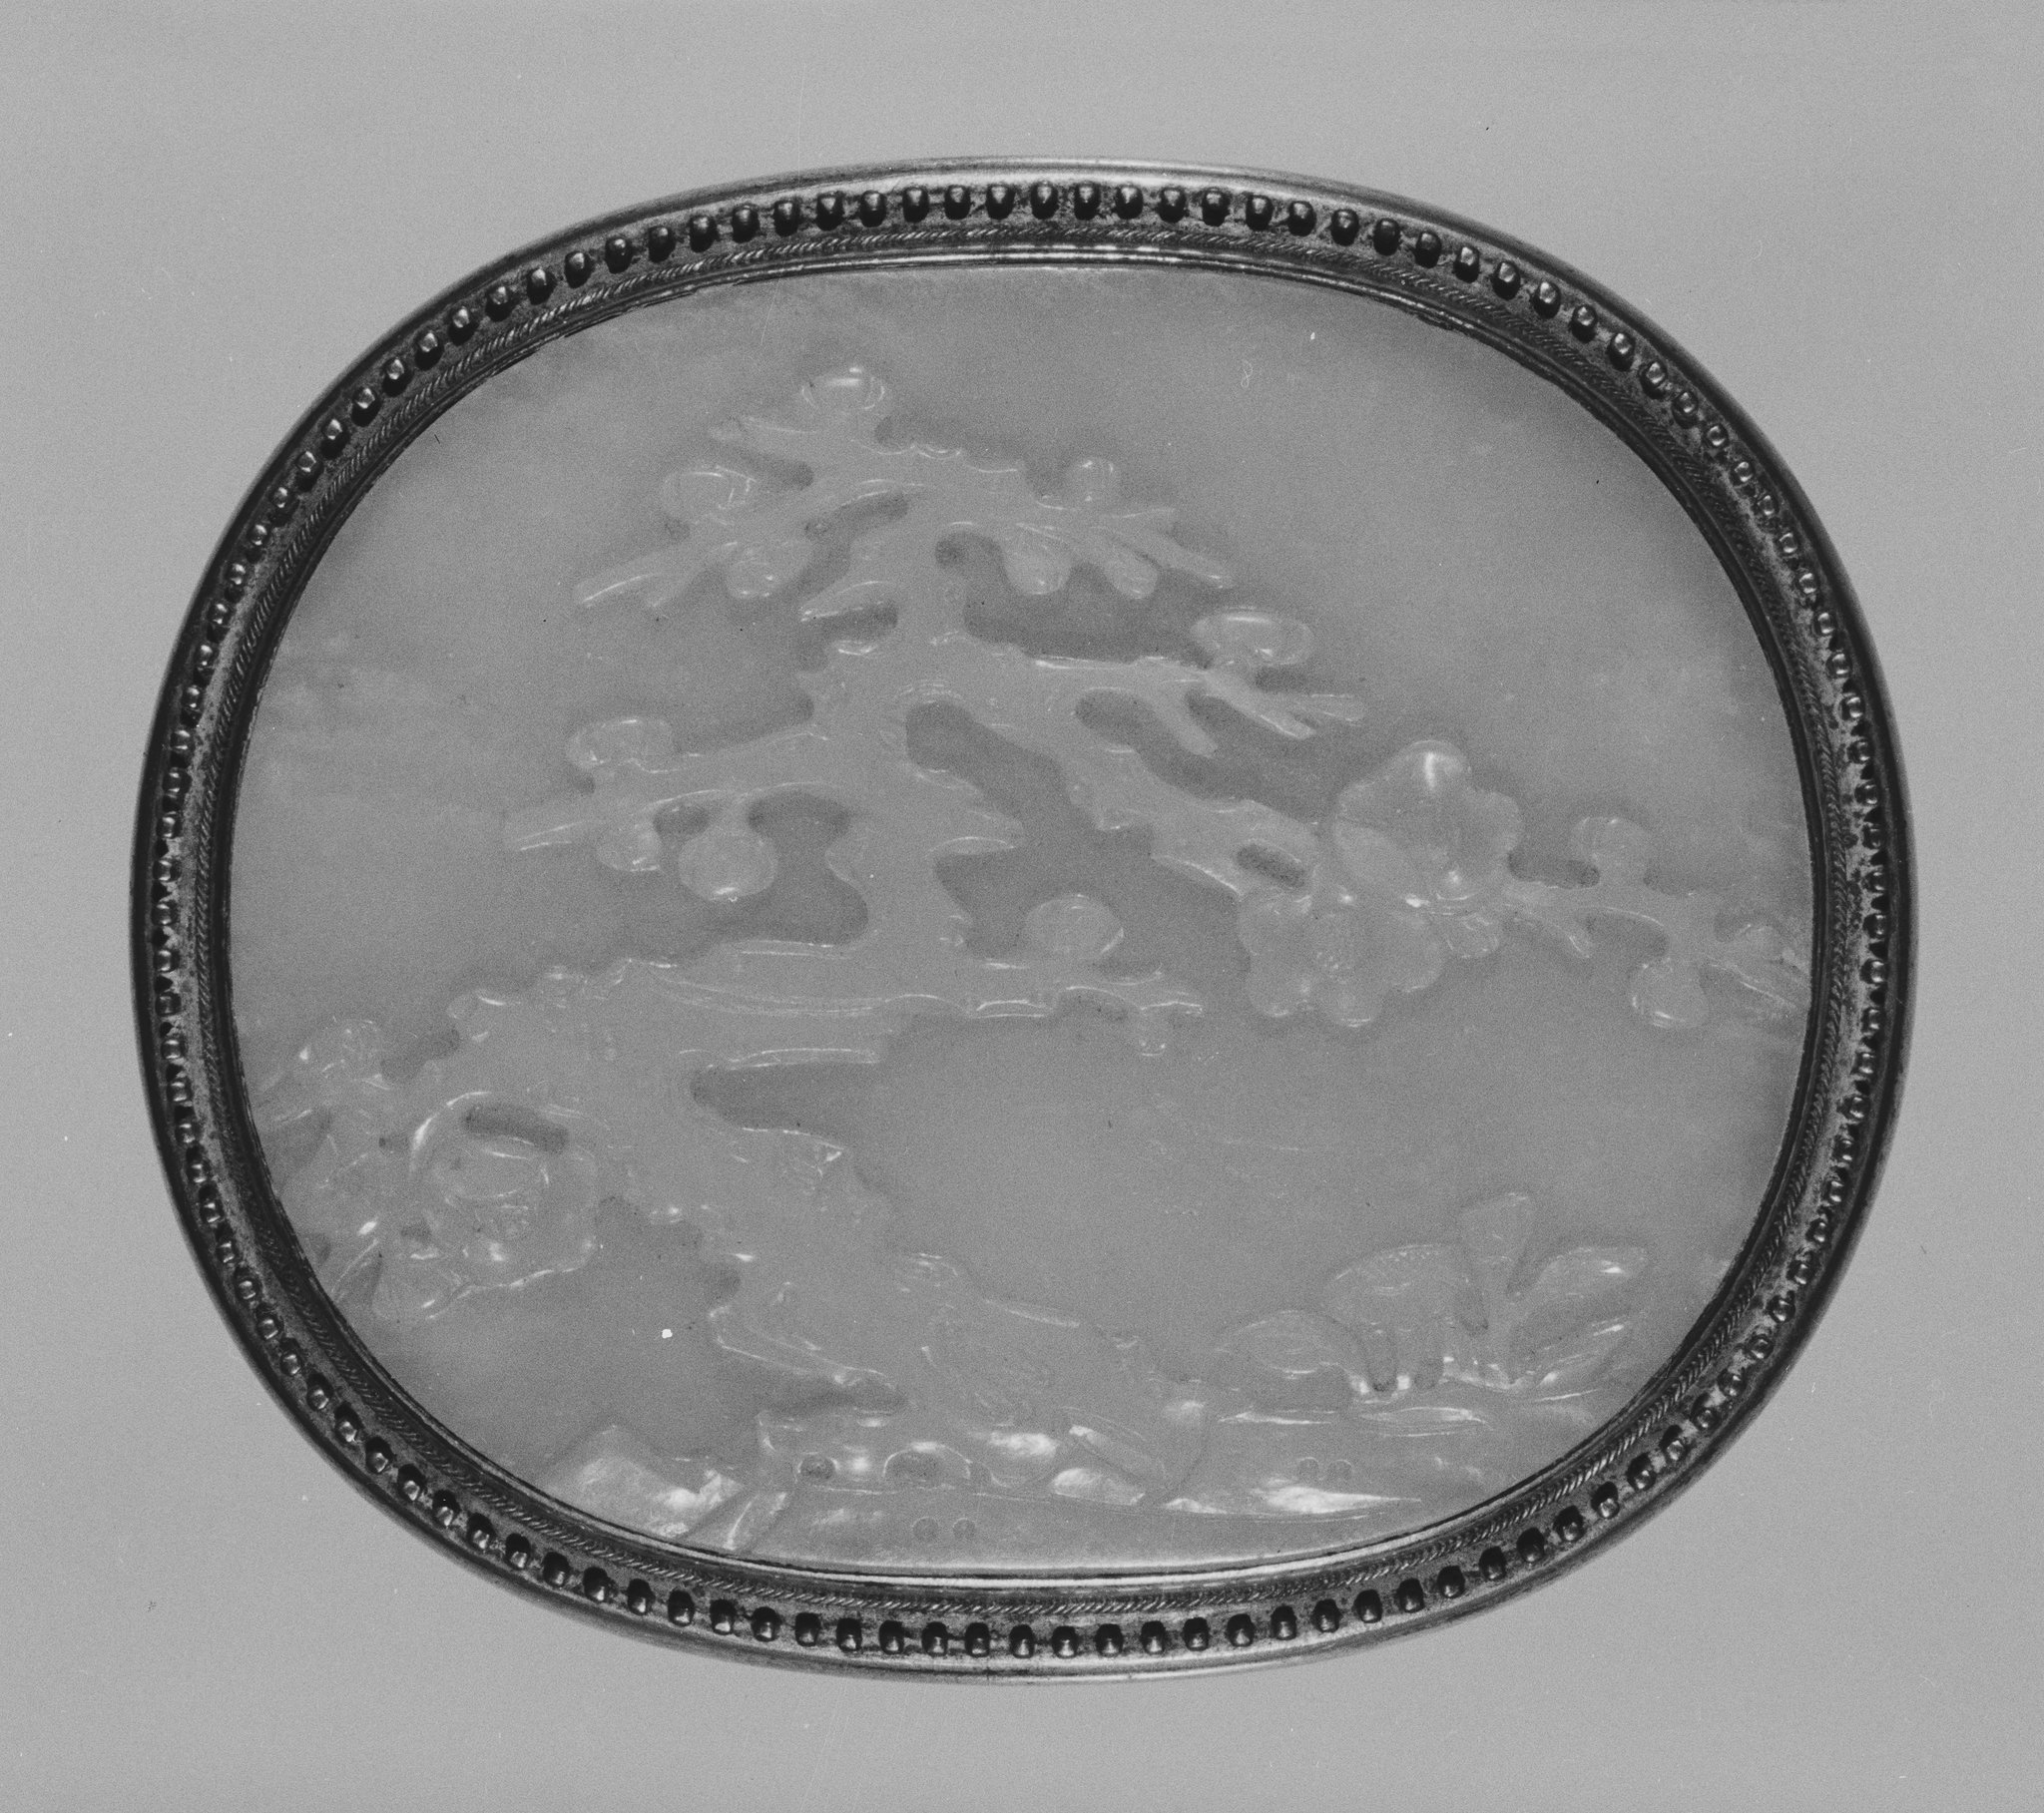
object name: sceptre plaque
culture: chinese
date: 1701-1800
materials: jade